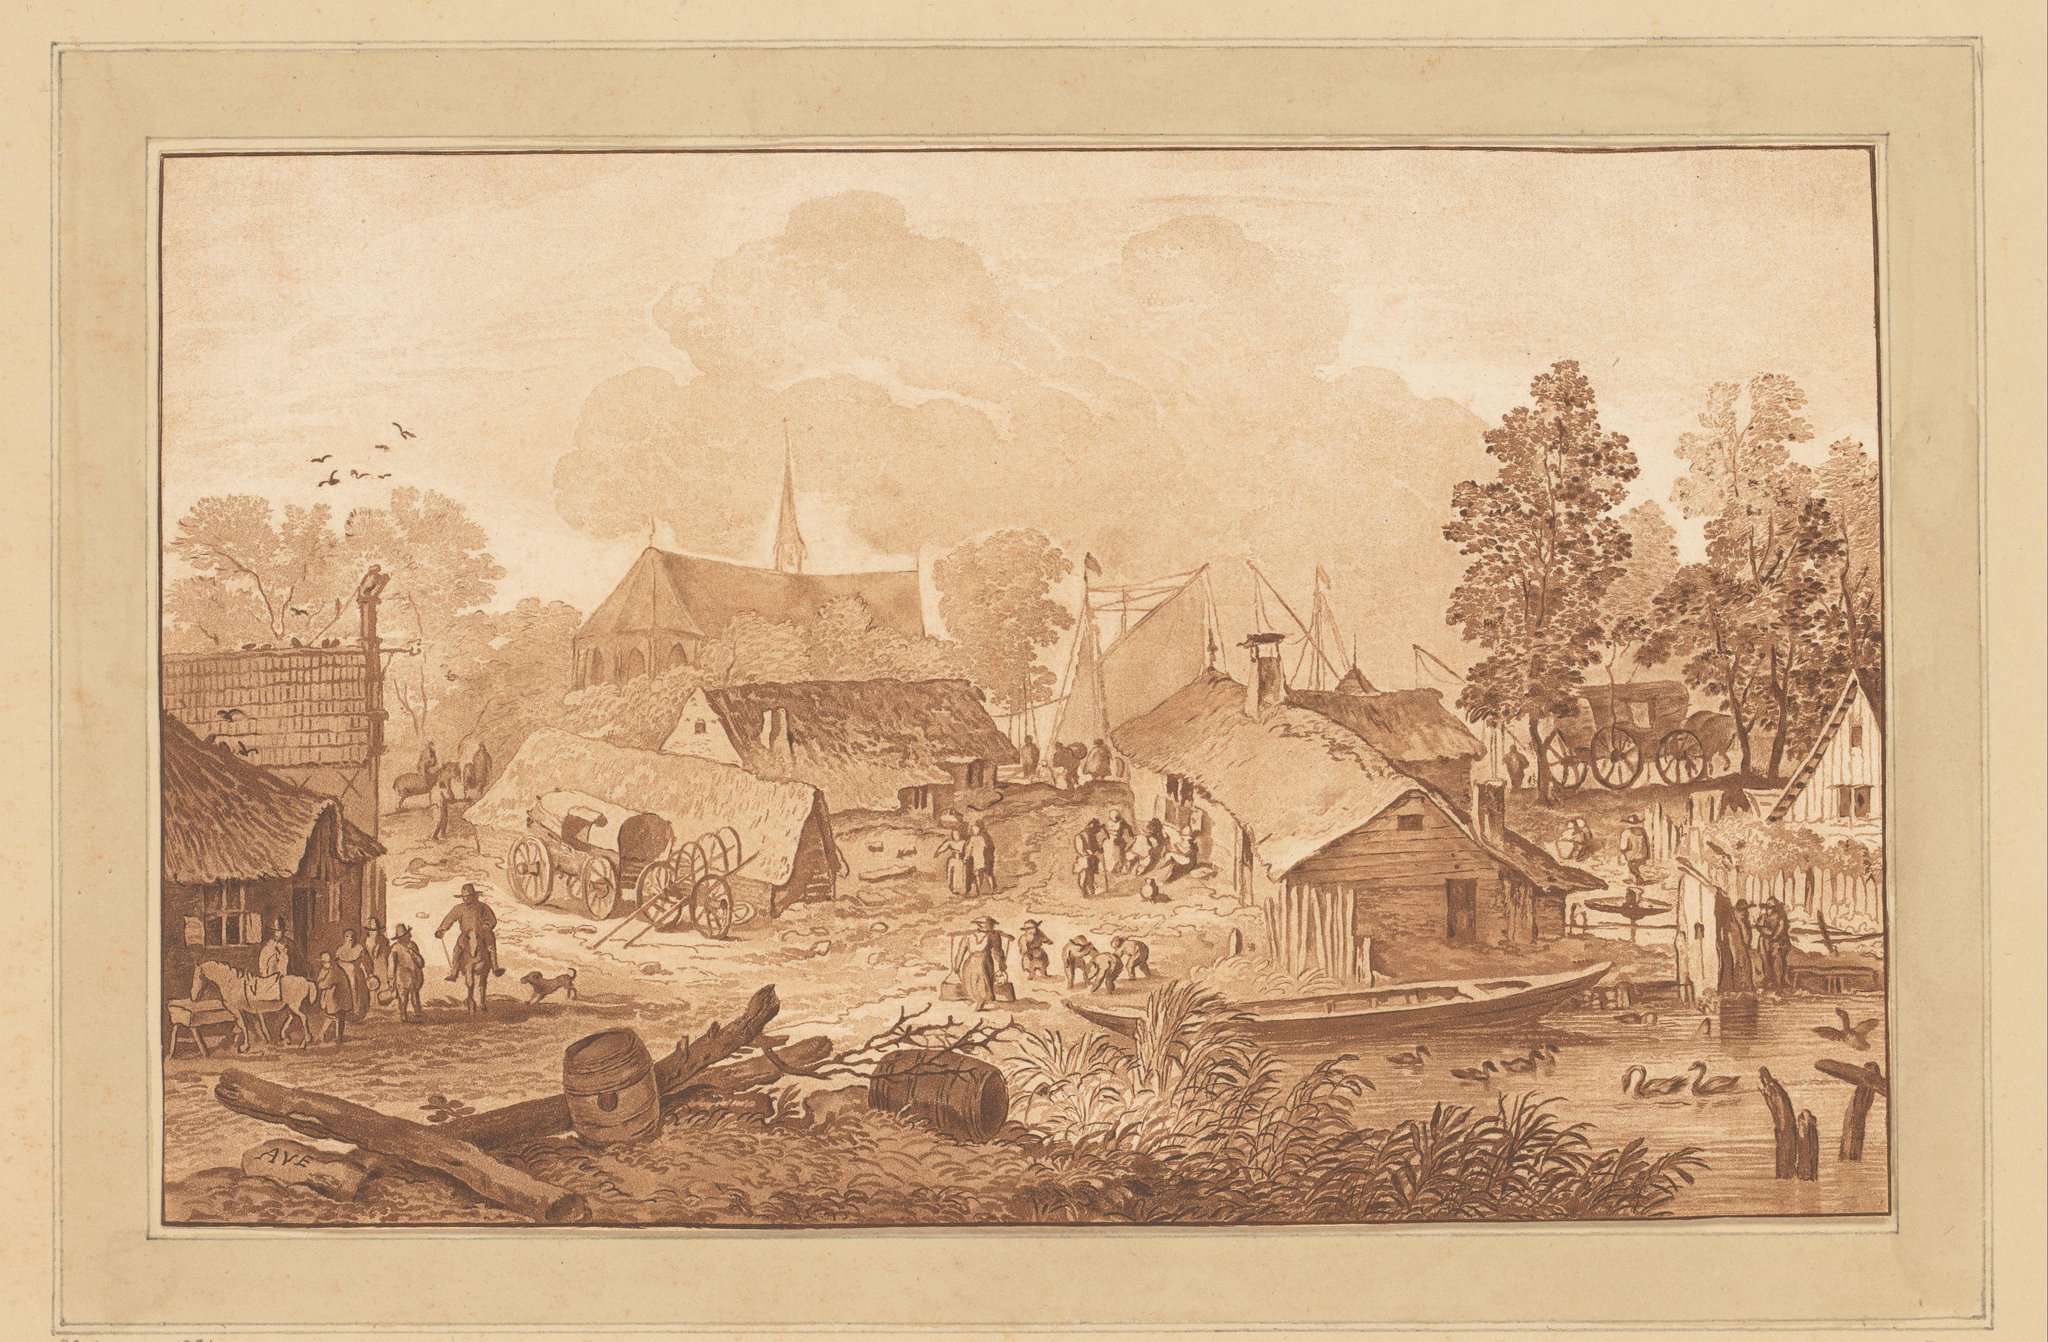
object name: print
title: Dorpsgezicht met vijver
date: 1782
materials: paper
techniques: etching, roulette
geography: amsterdam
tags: village, pond, pool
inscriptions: collector's mark: ‘RIJKS / MUSM’, collector's mark: Lugt 2725, inscription: ‘All. v. Everdingen. del. CPloos van Amstel. J.C. F. 1782’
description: Een dorp met rechts op de voorgrond een vijver. Op de achtergrond de zeilen en masten van schepen. De prent ligt los in een album, zie blad 36.